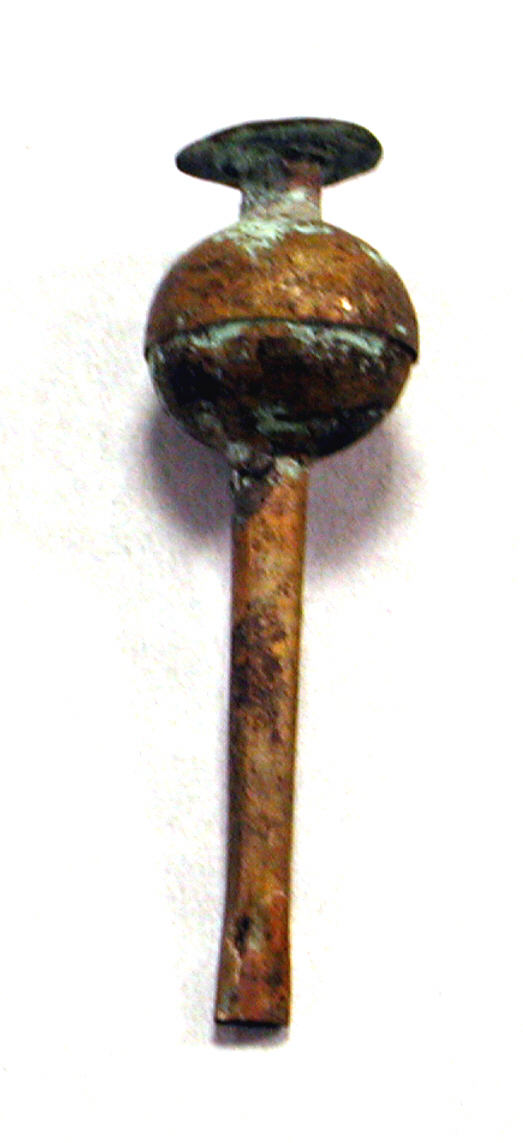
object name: scepter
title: Hammered Silver Miniature Scepter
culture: peruvian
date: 701-1566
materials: copper, gilt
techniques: hammering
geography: peru